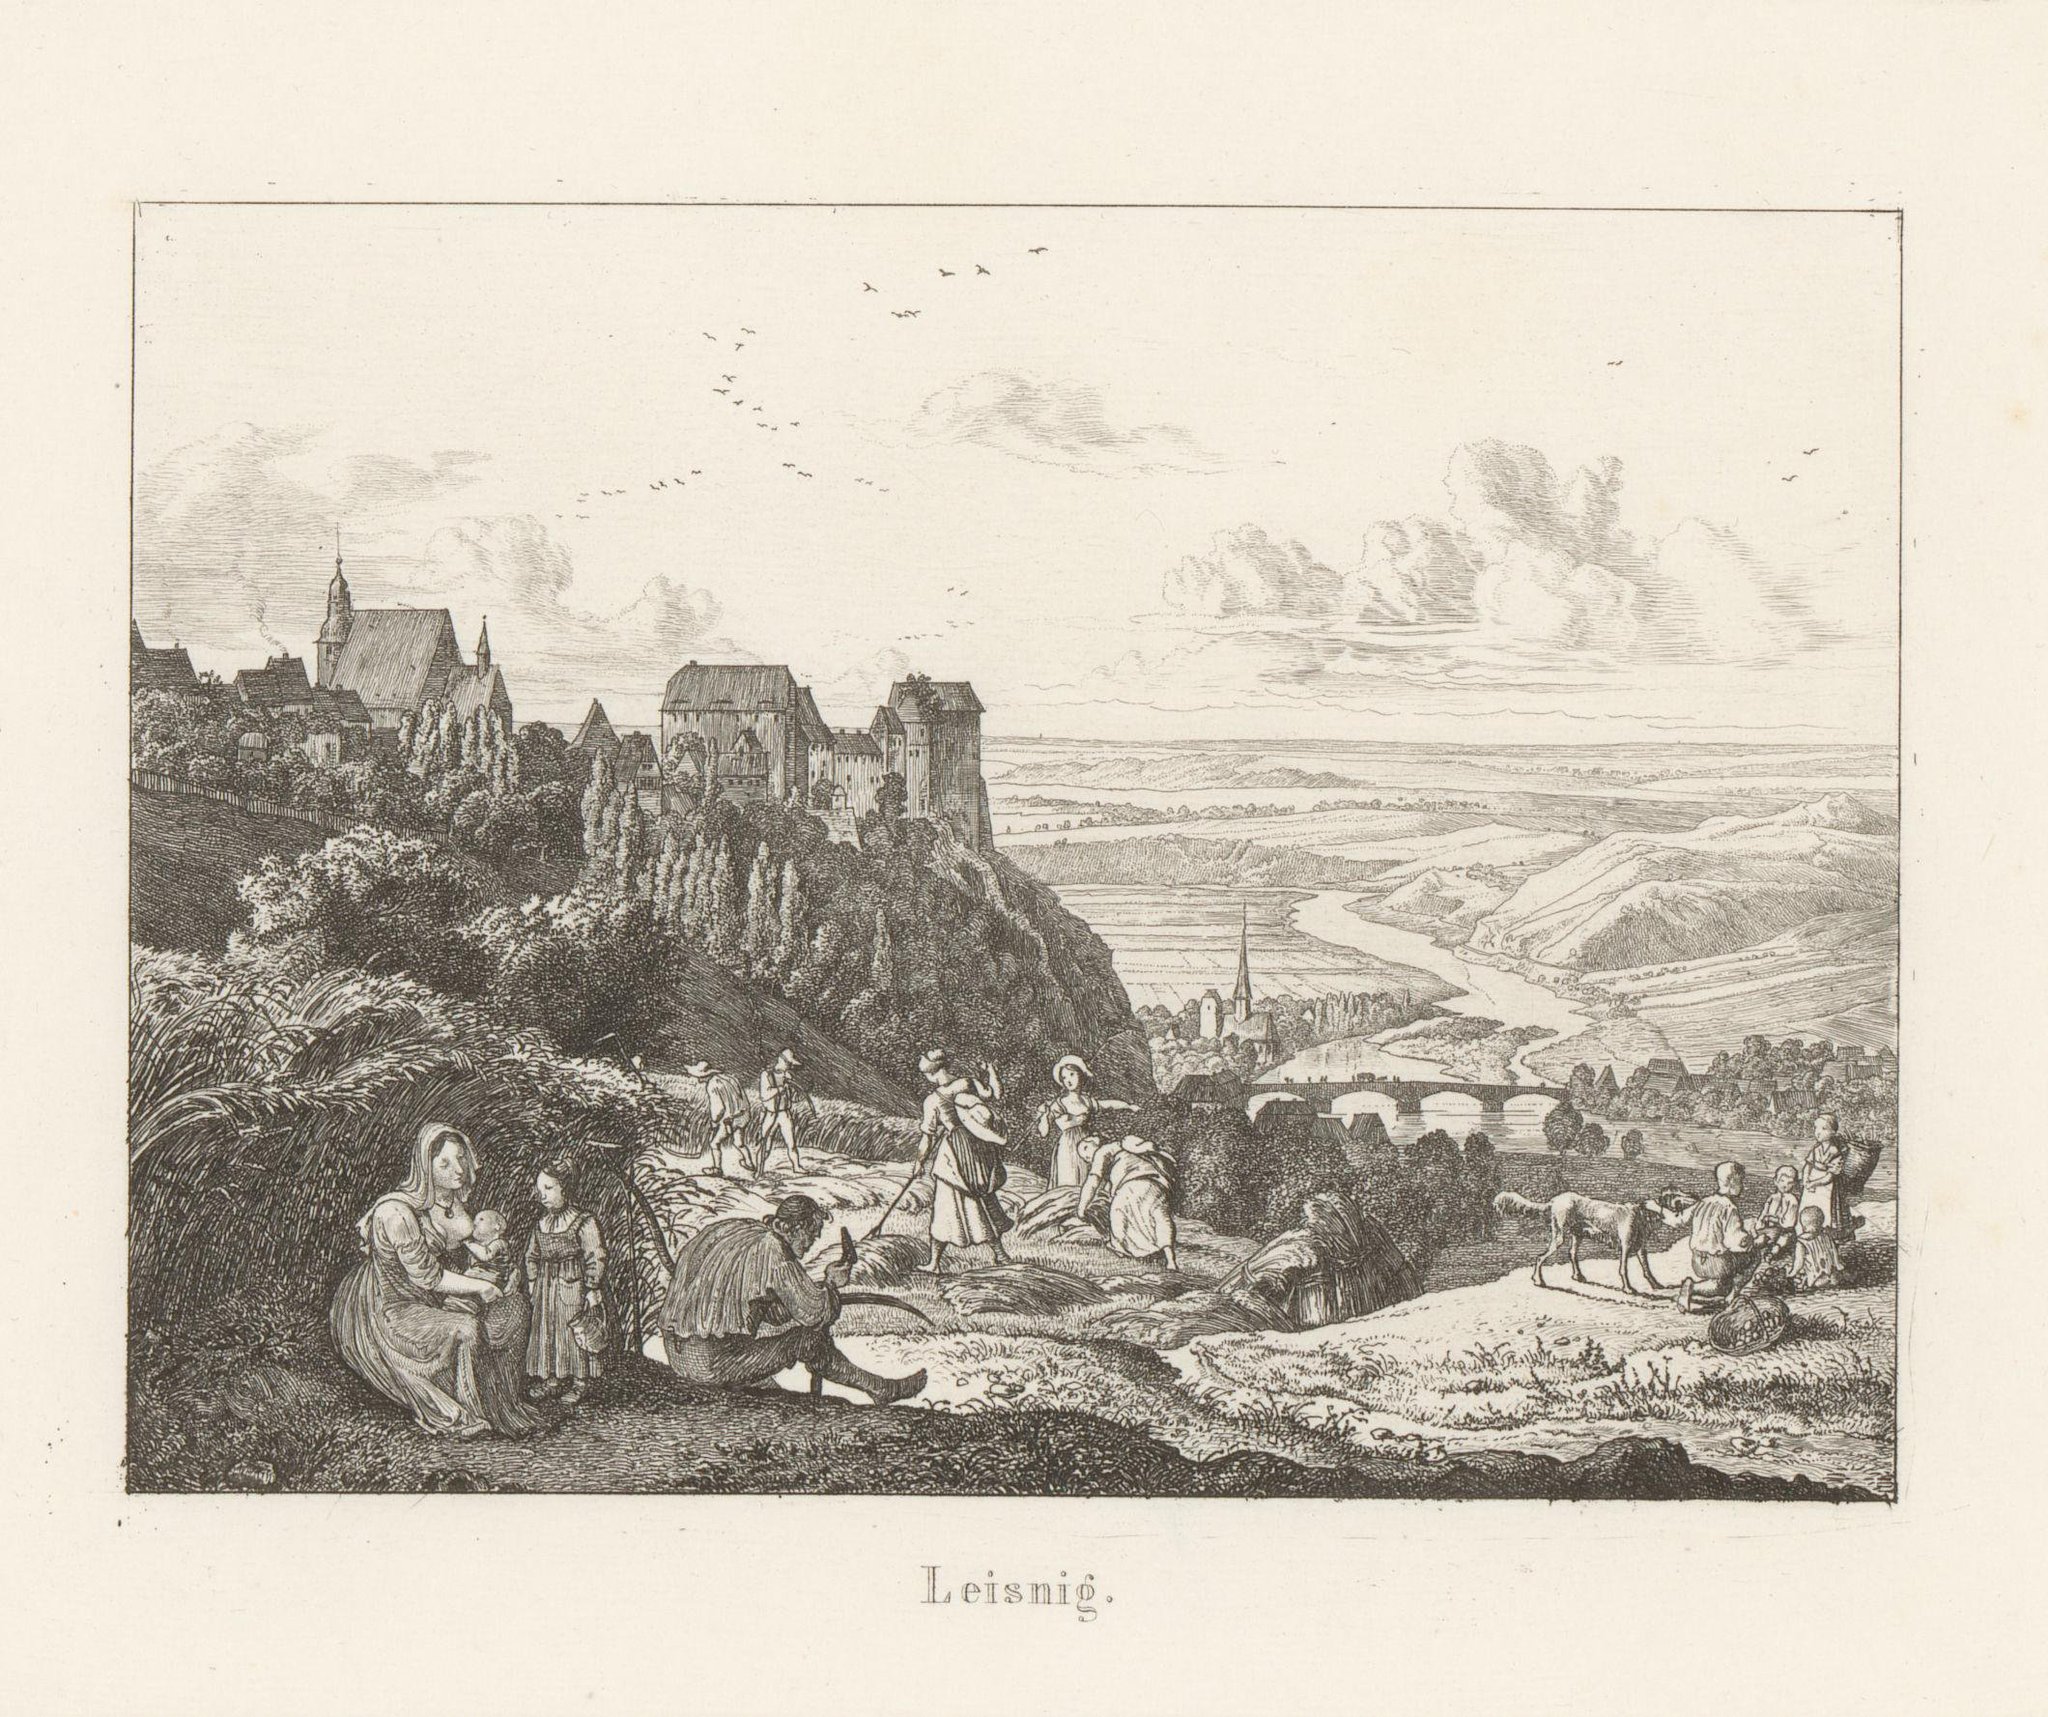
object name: print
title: Gezicht op Leisnig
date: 1828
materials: paper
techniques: etching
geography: leipzig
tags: landscape with monument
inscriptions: collector's mark: Lugt 2228